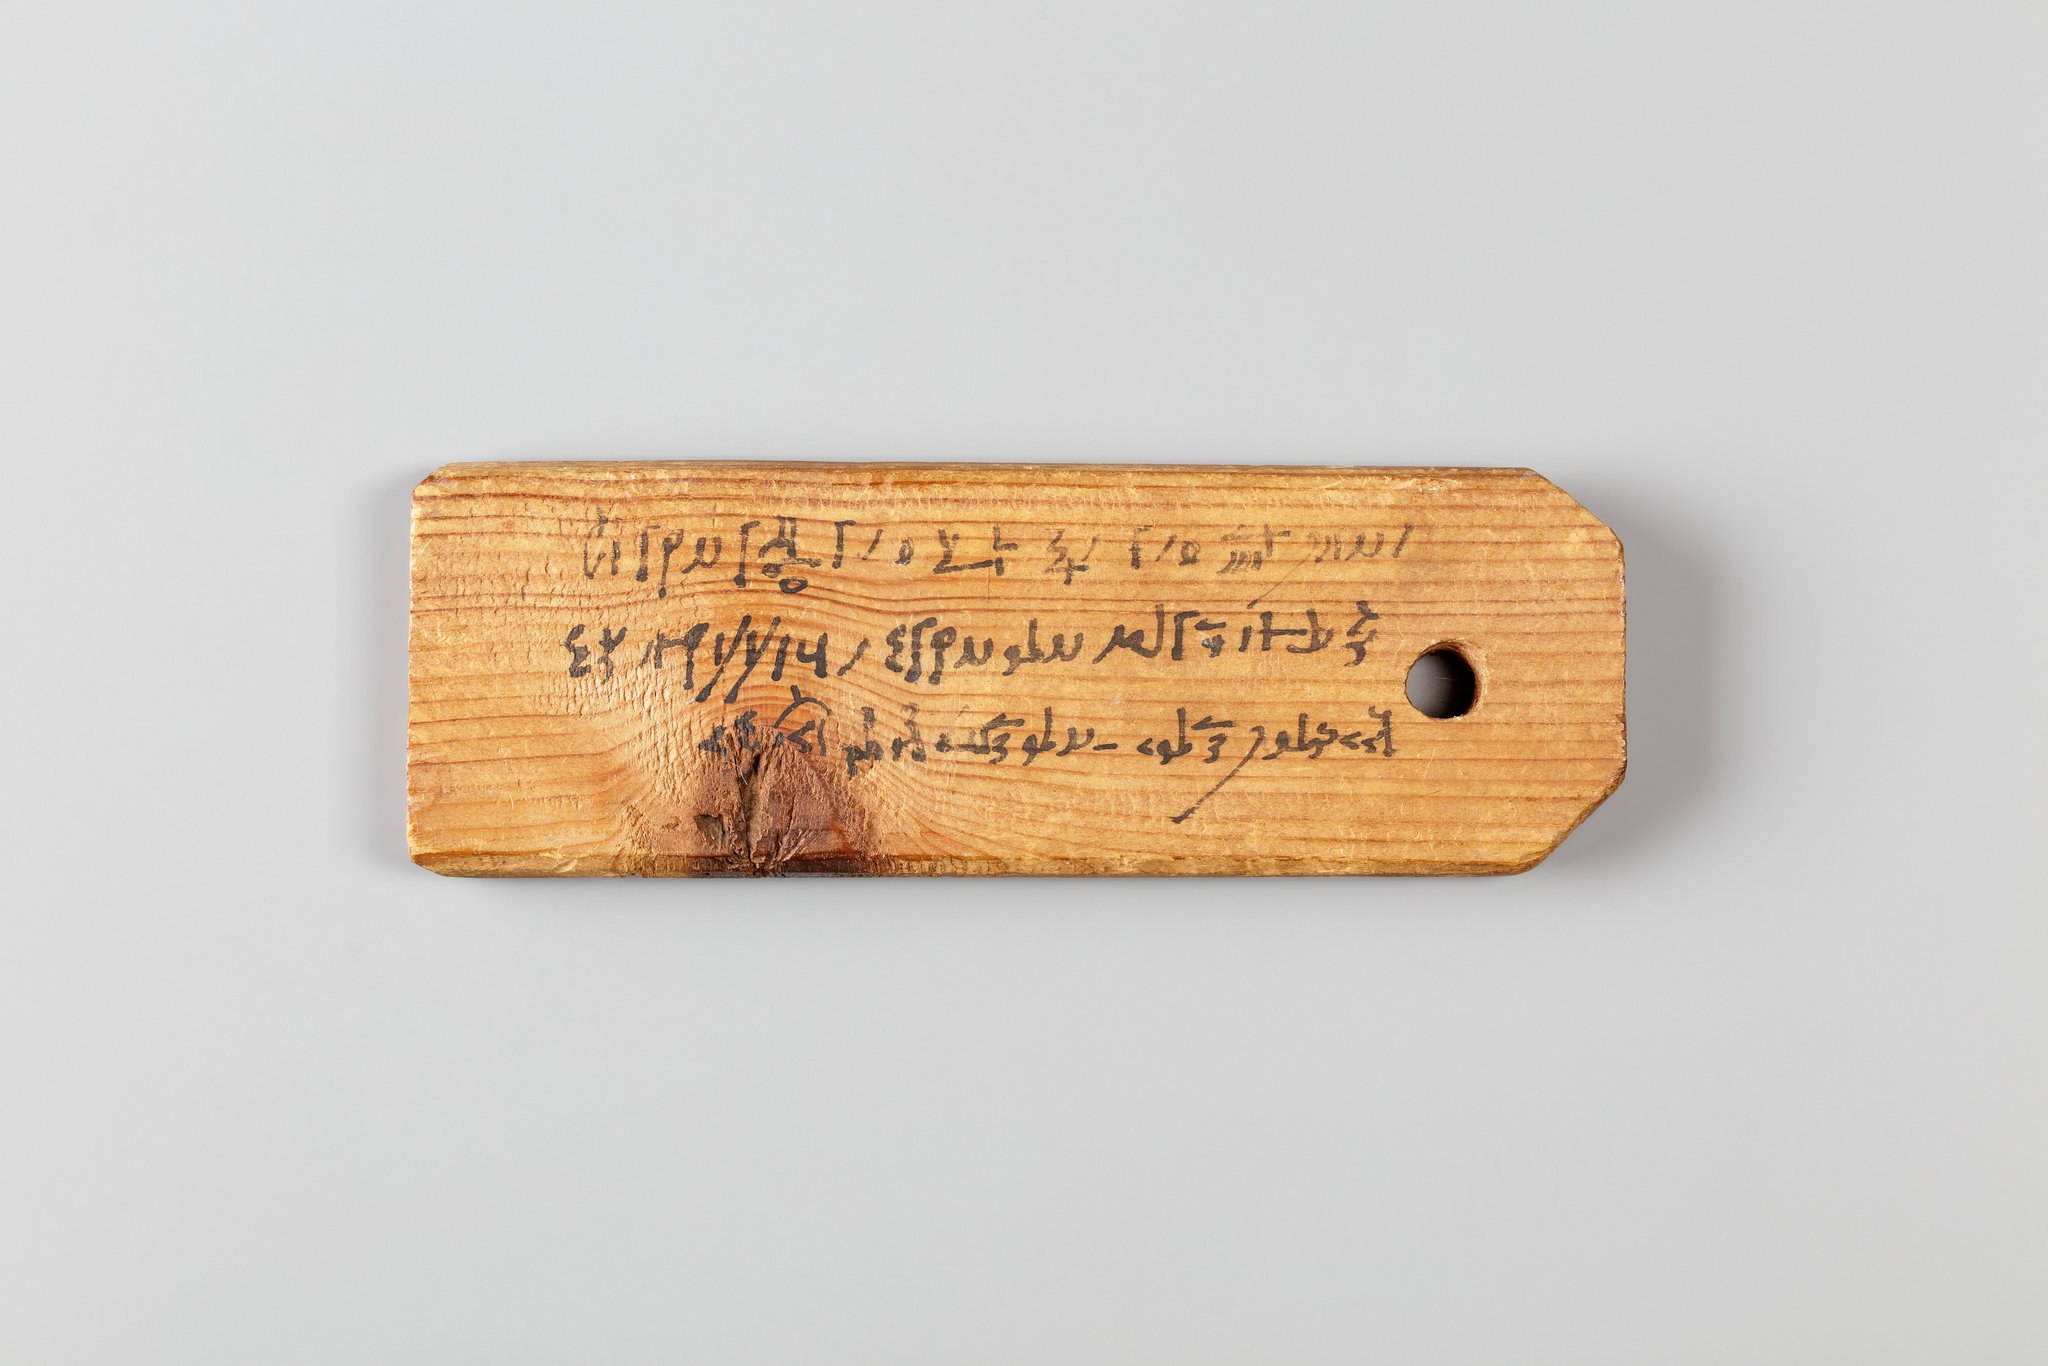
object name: mummy label, psenpnouthes, son of kollouthes, his mother senpsenthmesios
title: Mummy label of Psenpnouthes, (son of) Kollouthes; his mother Senpsenthmesios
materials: ink, wood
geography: northern upper egypt